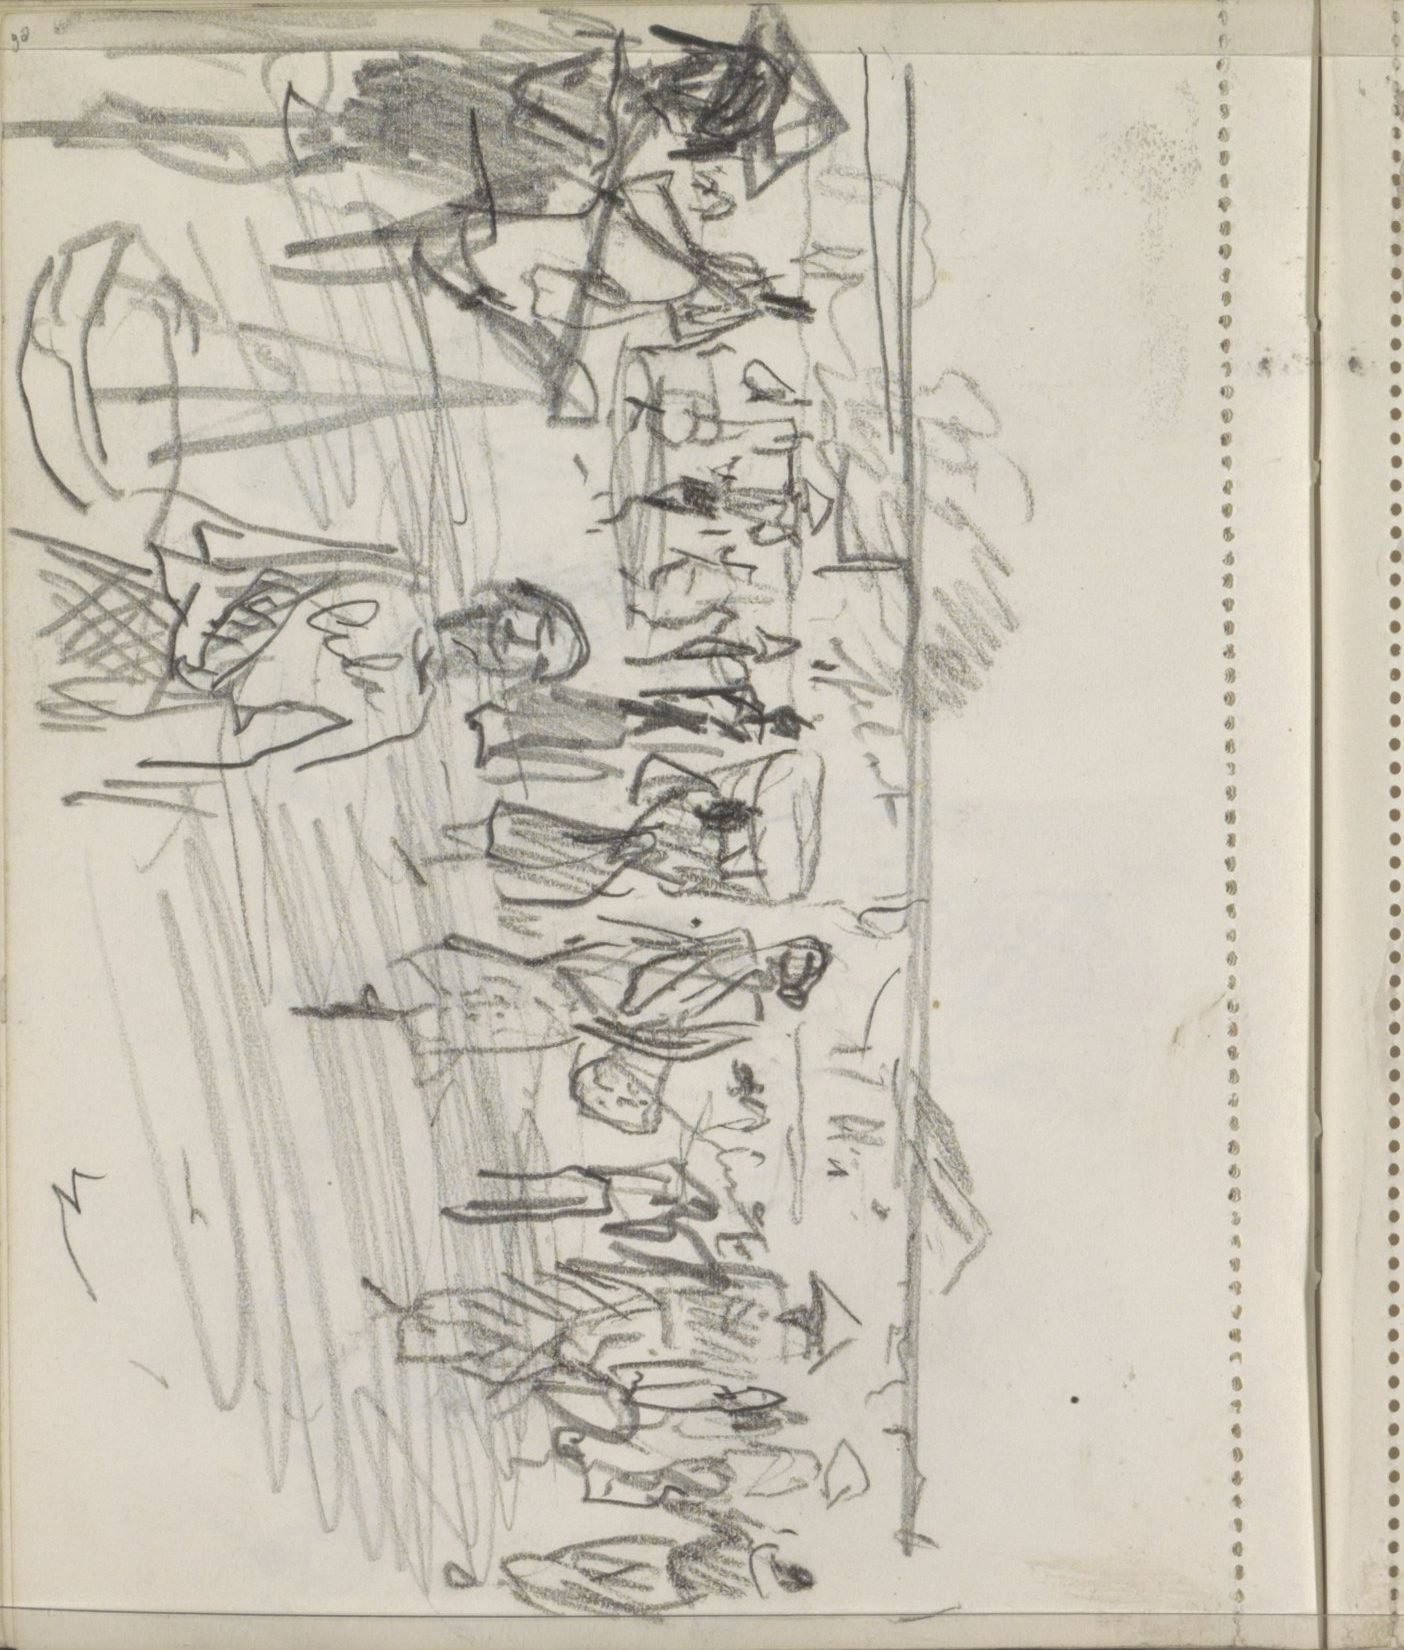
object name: sketchbook leaf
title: Weg met waterdragers en figuren met schalen op het hoofd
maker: marius bauer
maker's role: draughtsman, print maker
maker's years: 1867-1932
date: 1925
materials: paper, pencil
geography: indonesia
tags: asiatic races and peoples, carrying something on the head or on the shoulders, street (+ city(-scape) with figures, staffage)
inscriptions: kleurnotitie, handgeschreven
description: Pagina 98 uit een schetsboek met 67 bladen.